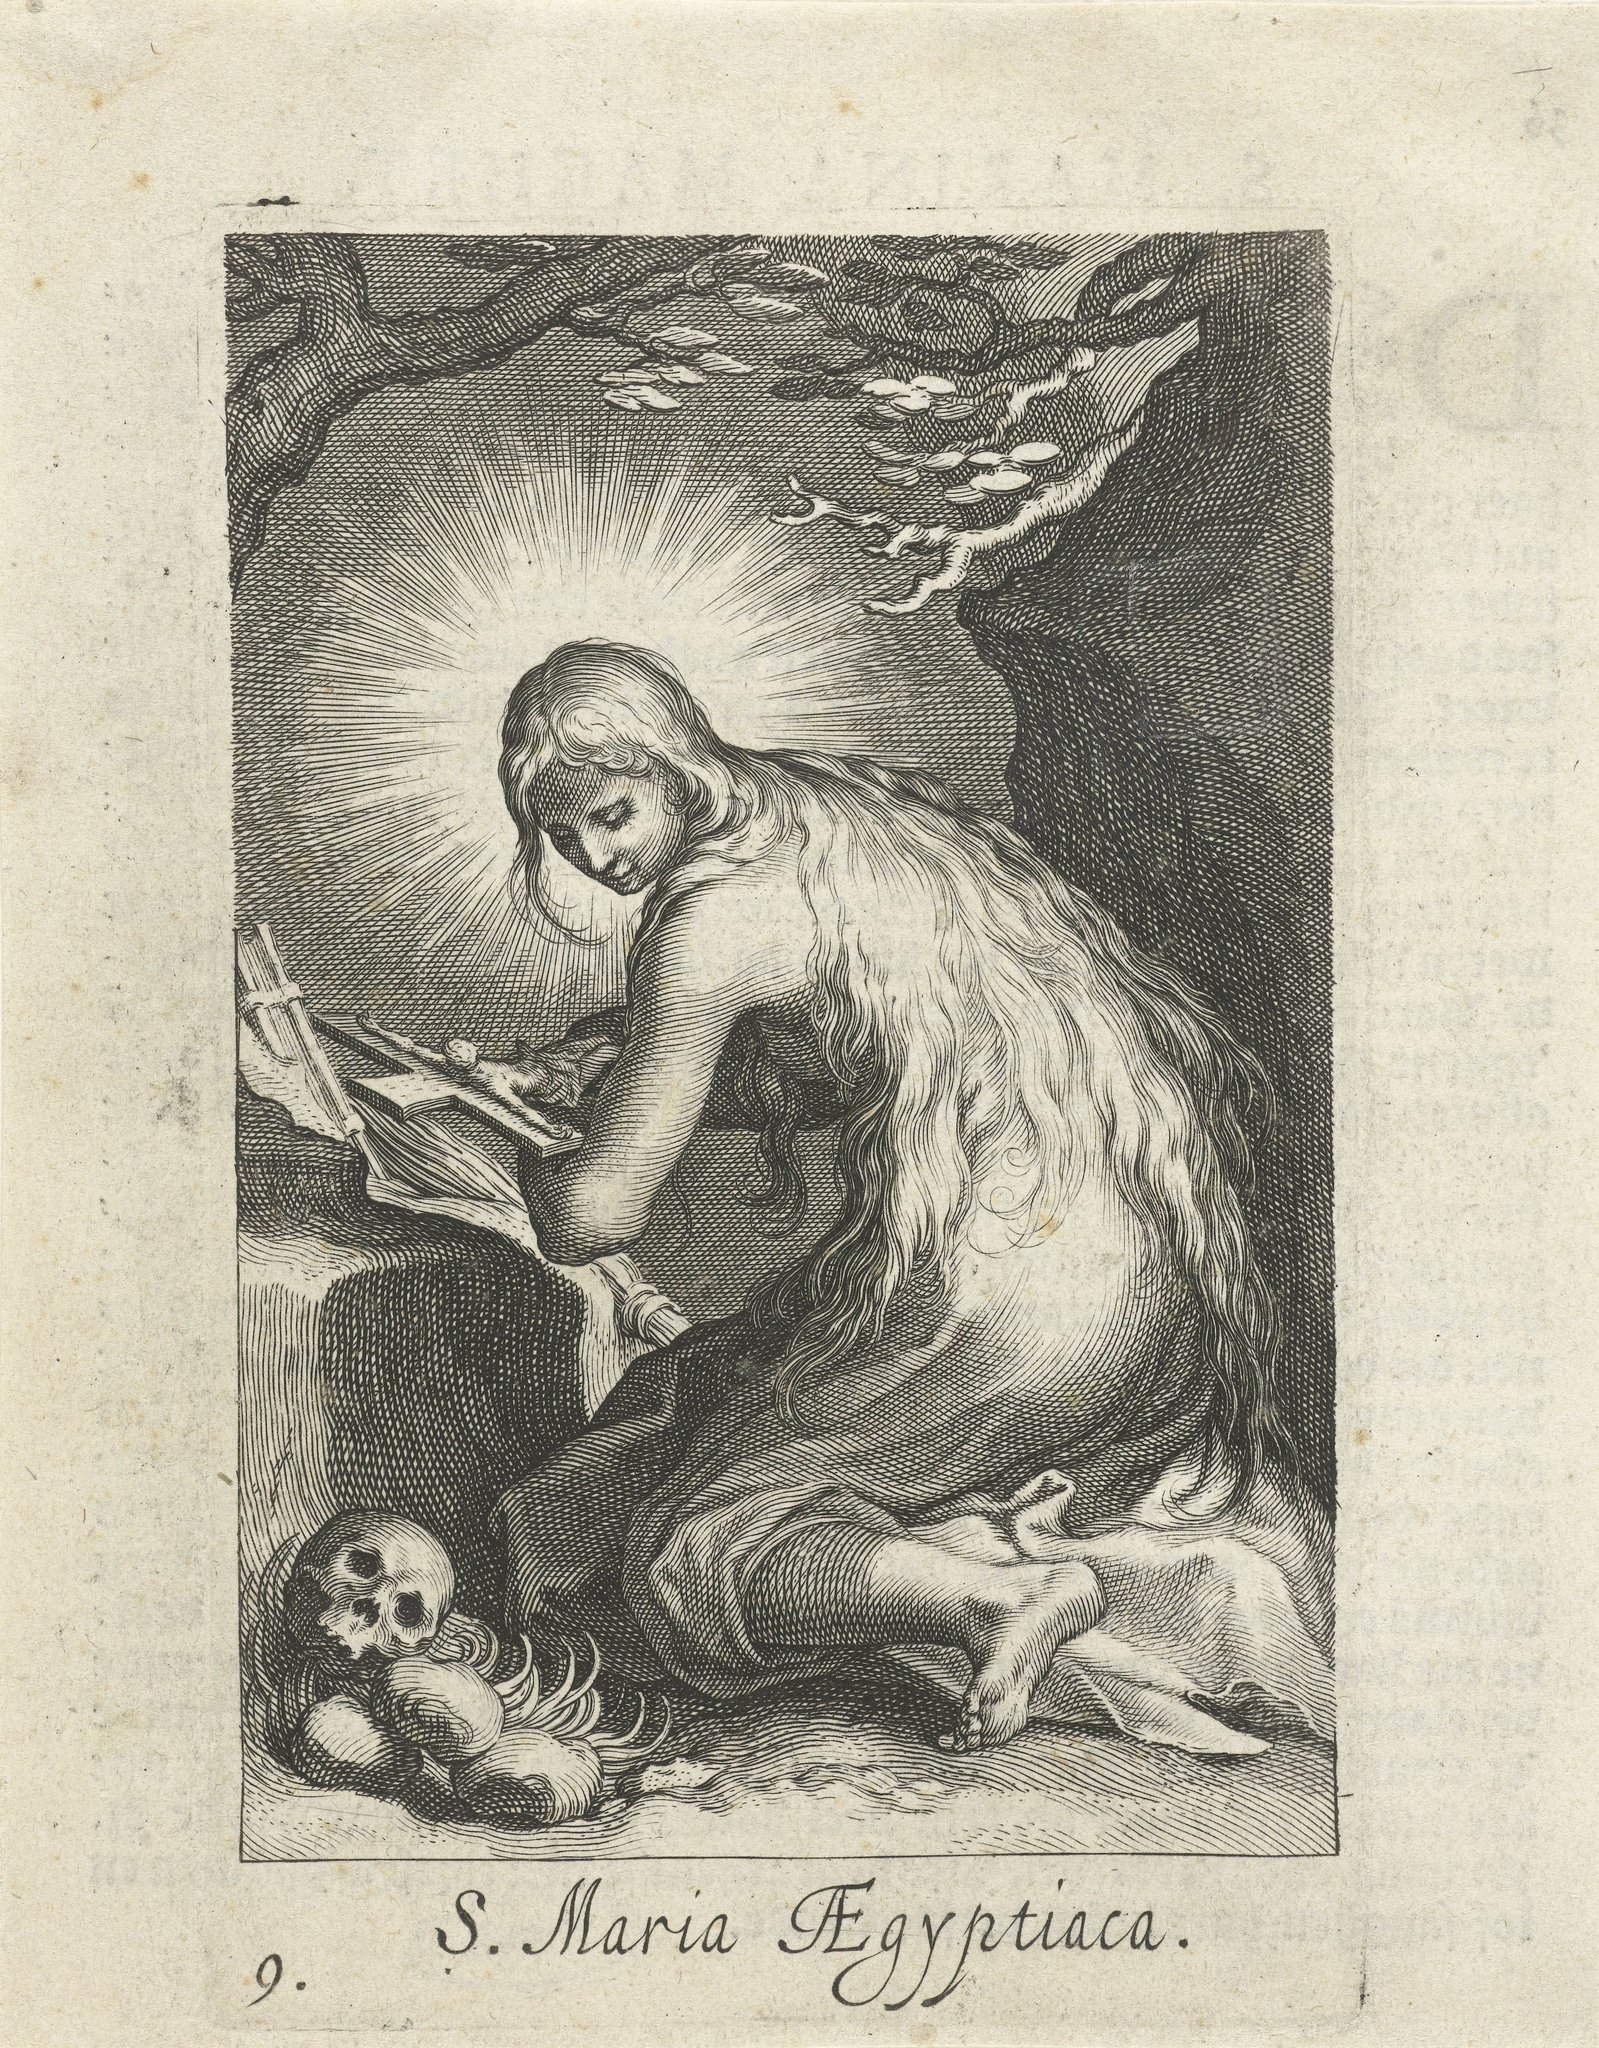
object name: book illustration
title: Heilige Maria van Egypte als kluizenares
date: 1590-1612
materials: paper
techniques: engraving, letterpress printing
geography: antwerp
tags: the penitent harlot mary of egypt (maria aegyptiaca); possible attributes: long hair, three loaves, anchorite, hermit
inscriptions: collector's mark: Lugt 2228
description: Prent uit: Sacra eremus ascetriarum, Hendrik Aertssen, Antwerpen 1619 of uit: Ad sacrum speculum … Patribus dat ales, Boëtius Adamsz. Bolswert, Amsterdam of Antwerpen1612. Prent uit de serie van vijfentwintig kluizenaressen in deze uitgaven. In 1612 verscheen de ongebonden editie maar op basis van de gewijzigde opschriften en samenstelling van de serie kluizenaars wordt aangenomen dat de prenten van de uitgave 1619 ook in 1612 of iets daarvoor gedrukt werden. De serie kluizenaressen bleef vrijwel ongewijzigd in de ongebonden uitgave van 1612, dit compliceert de datering van de losse bladen in de collectie van het RMA, zie Roethlisberger 1993, p. 171-175.